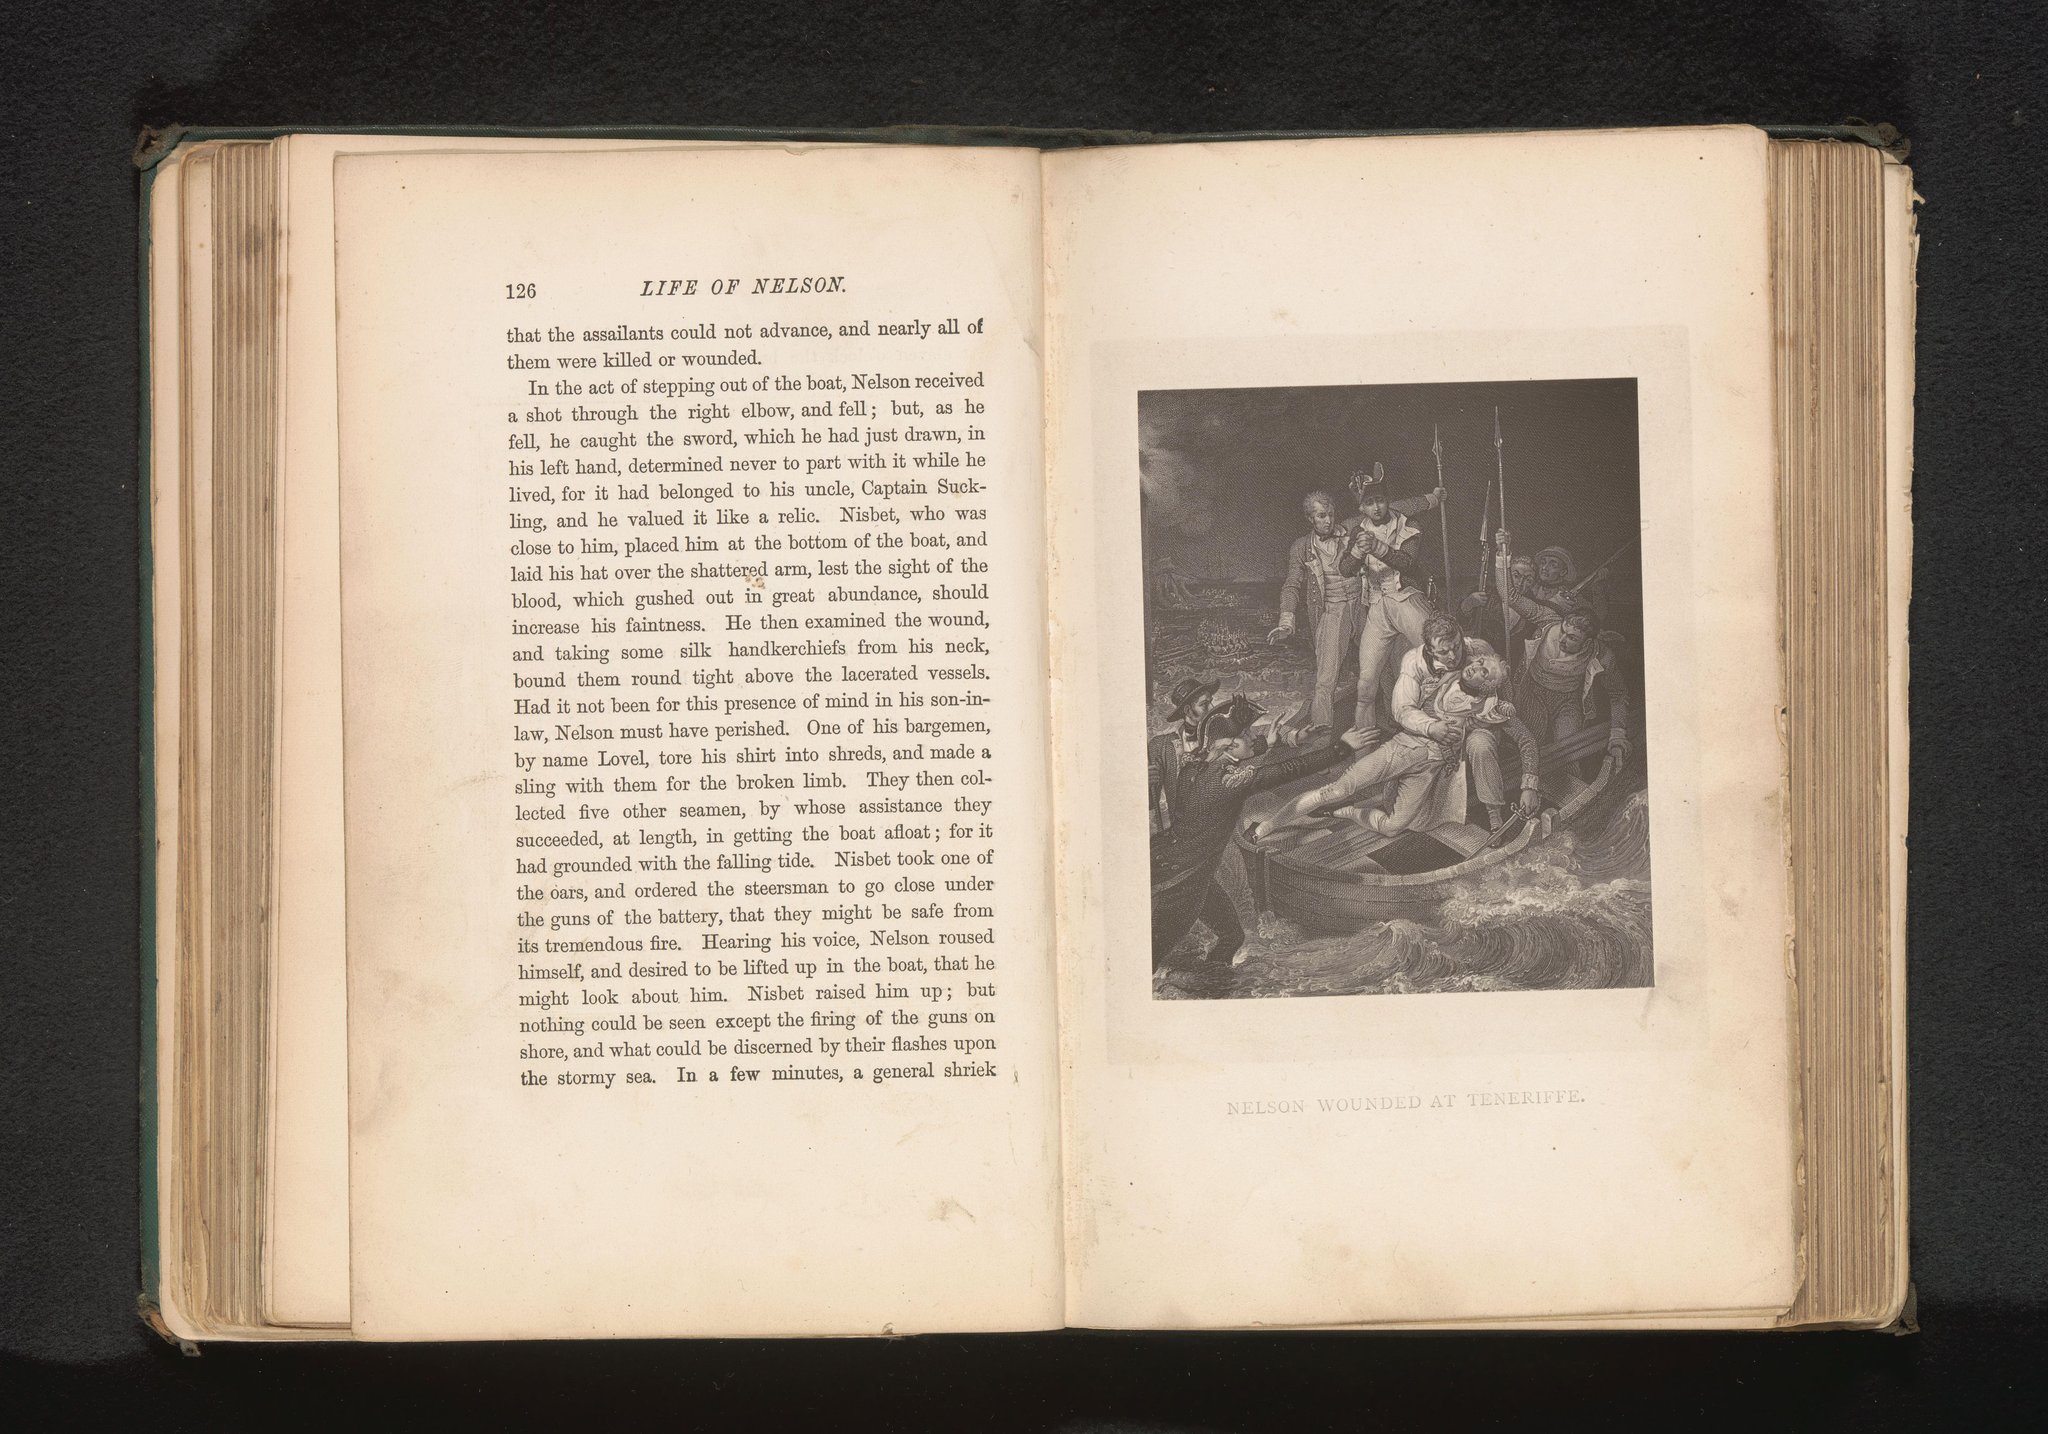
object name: reproduction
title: Fotoreproductie van een prent van Horatio Nelson die gewond aankomt op Tenerife na de zeeslag bij Kaap Sint-Vincent in 1797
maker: Anonymous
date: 1877-1887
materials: paper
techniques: woodburytype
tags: horatio nelson (hertog van bronte), putting out of action by wounding, battle